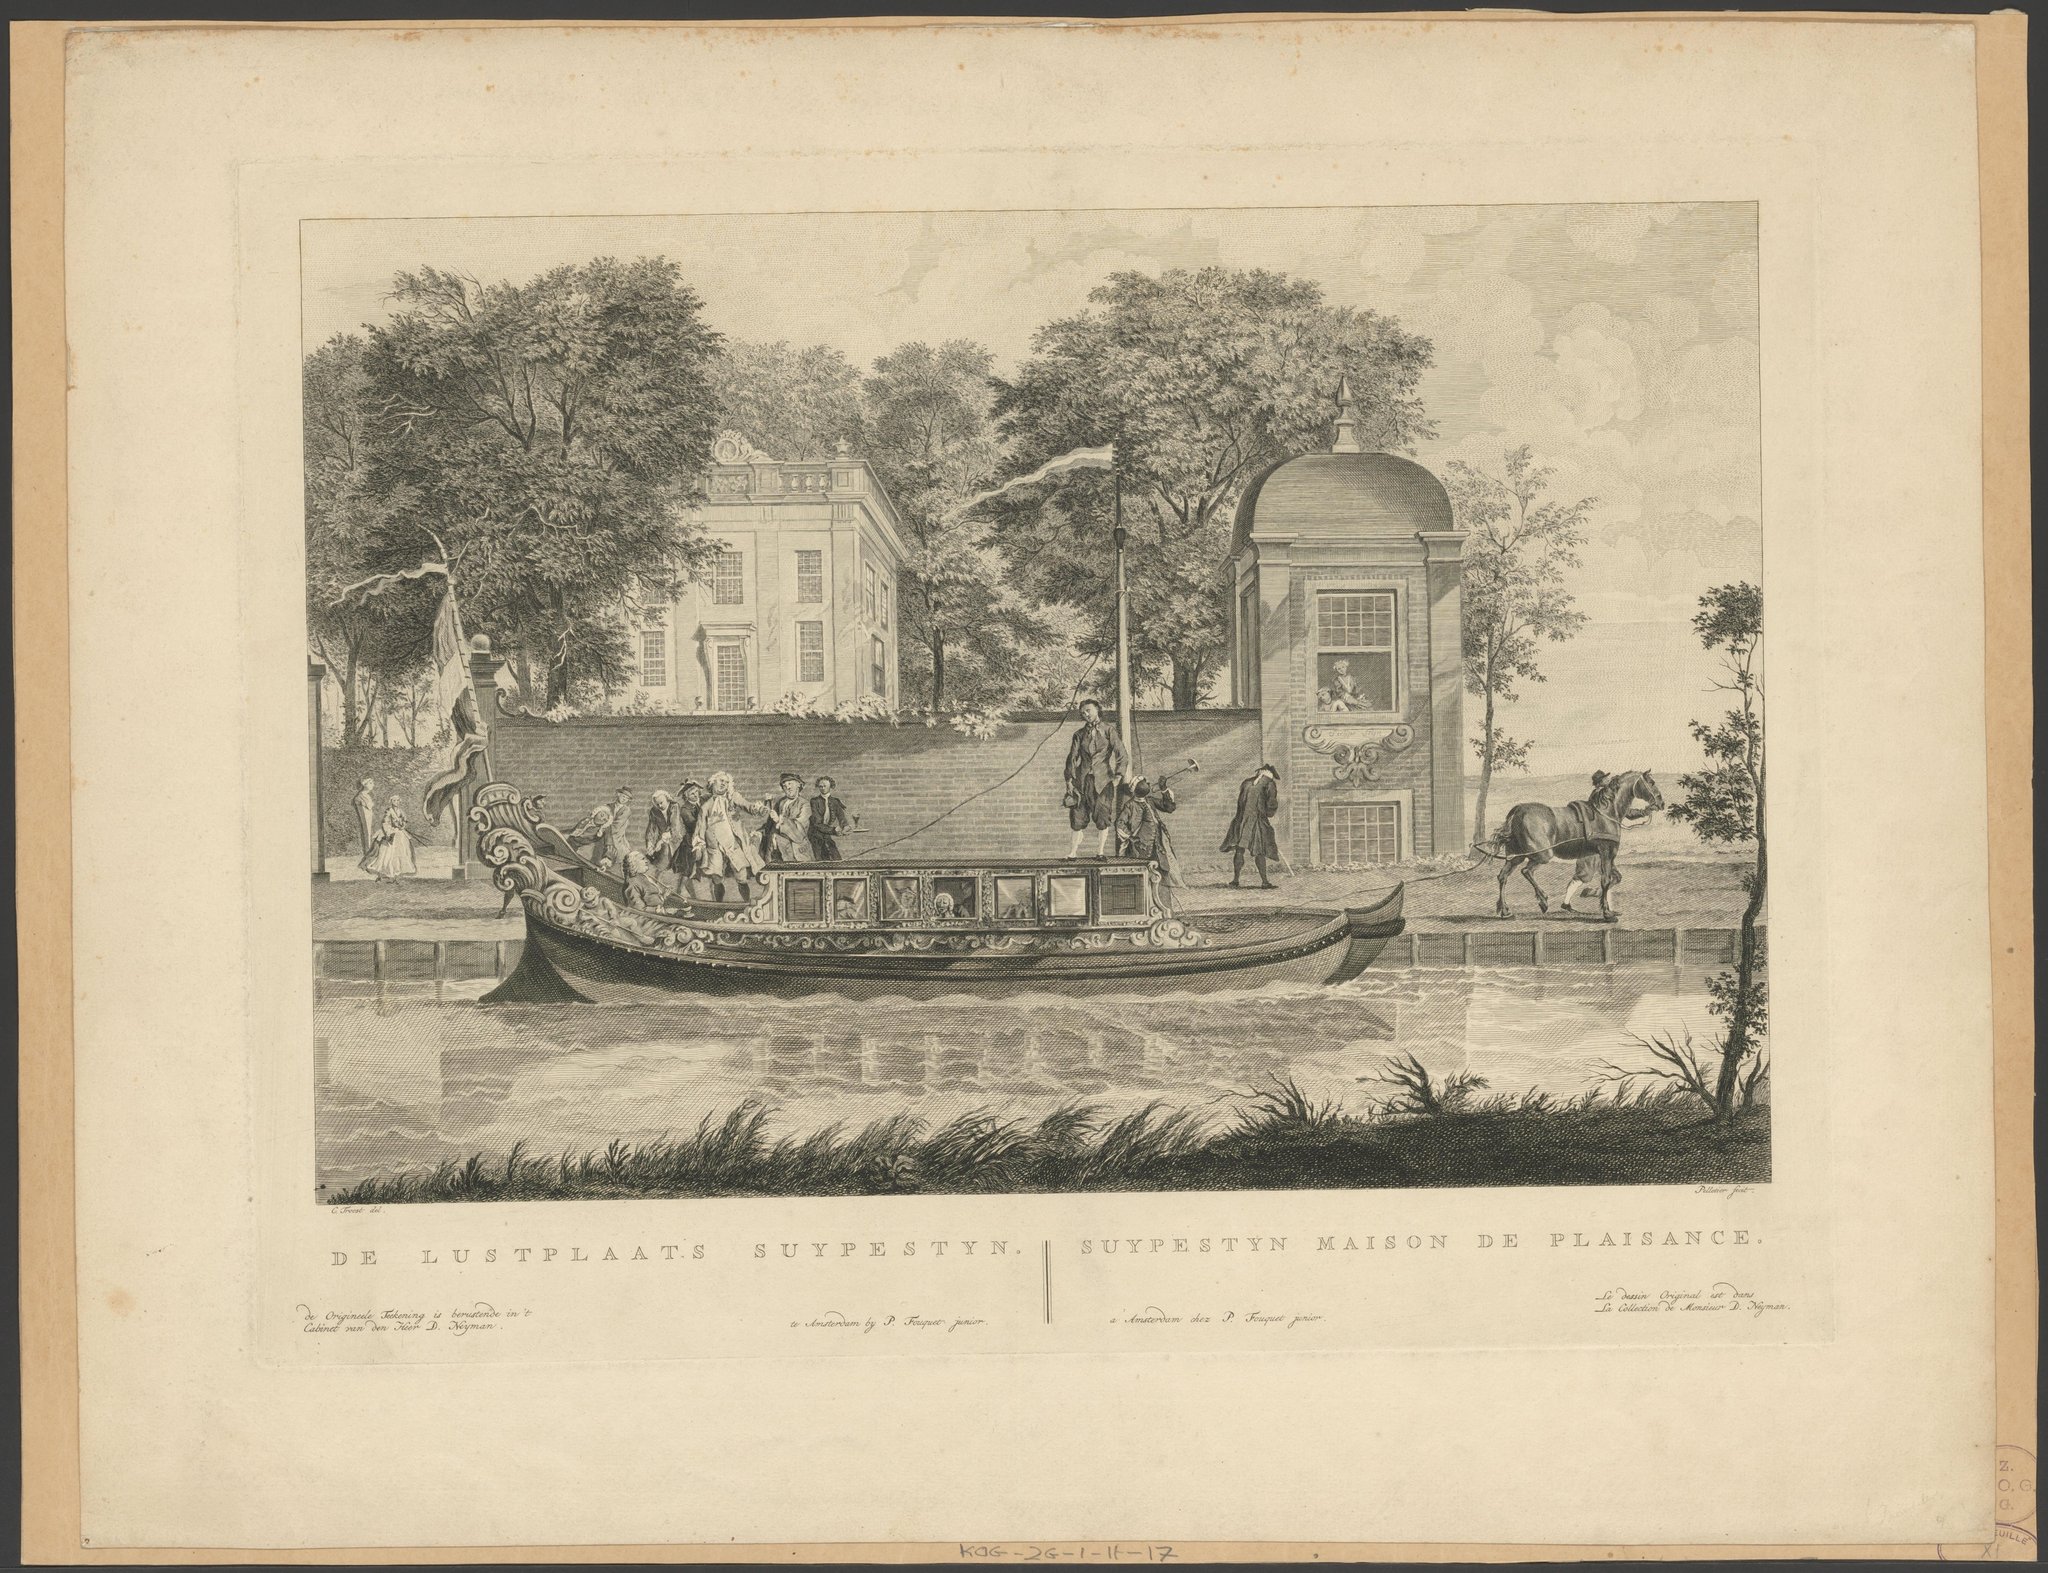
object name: print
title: De lustplaats Suypestyn / Suypestyn maison de plaisance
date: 1756-1780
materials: paper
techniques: engraving, etching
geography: amsterdam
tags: rural housing, e.g. country-house, villa, cottage, tow-boat, towing-barge, drunkenness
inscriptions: collector's mark: Lugt 1641, stamp:, collector's mark: Lugt 1641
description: Onderwerpsrubrieken binnen de Atlas Zeden en Gewoonten: Handel, nijverheid en verkeer, Vervoermiddelen te land en te water, Vervoermiddelen te water.